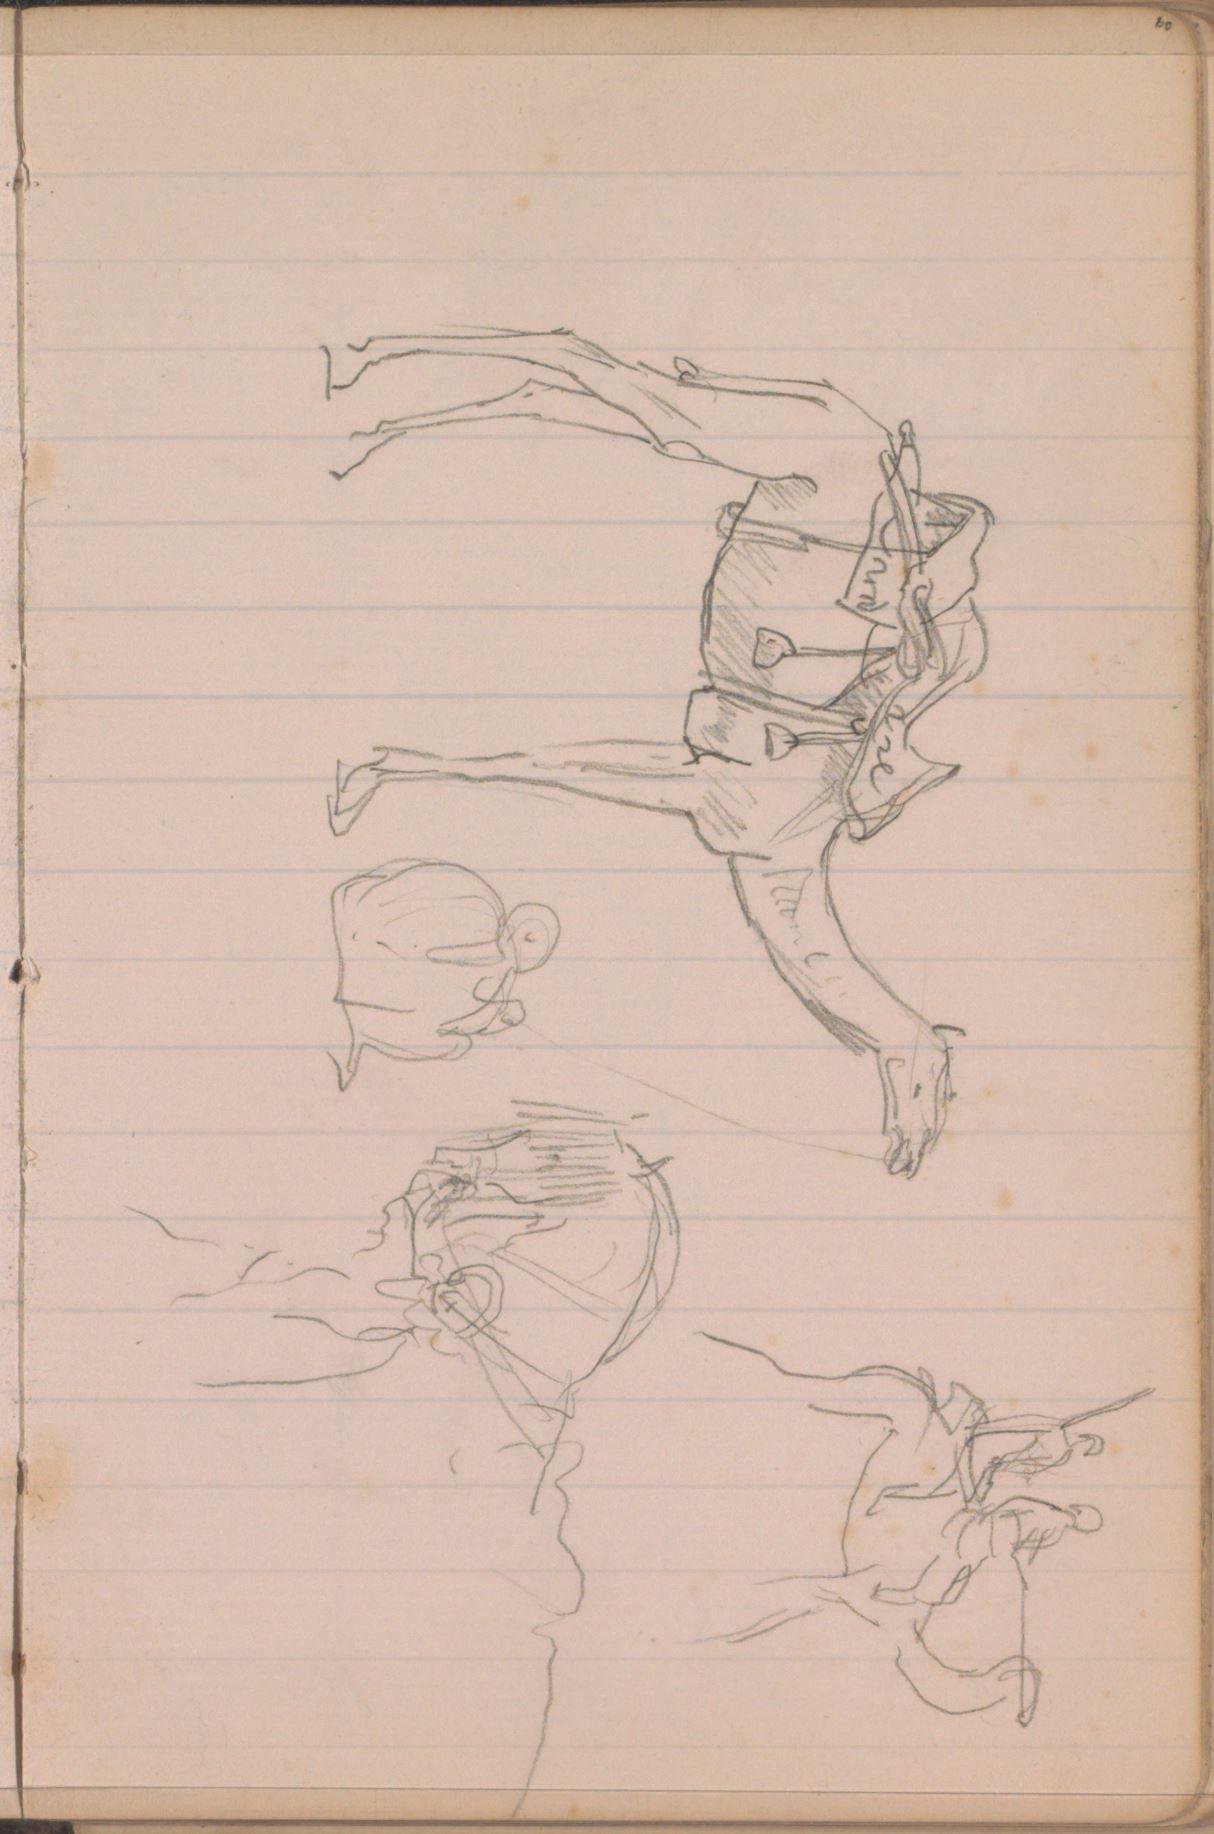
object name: sketchbook leaf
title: Kameel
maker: marius bauer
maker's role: draughtsman, print maker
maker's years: 1867-1932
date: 1897-1898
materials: pencil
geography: india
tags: hoofed animals: camel, sitting figure, saddle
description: De kameel draagt een zadel. Tevens een studie van figuren op een kameel. Pagina 60 uit een schetsboek met 84 bladen.